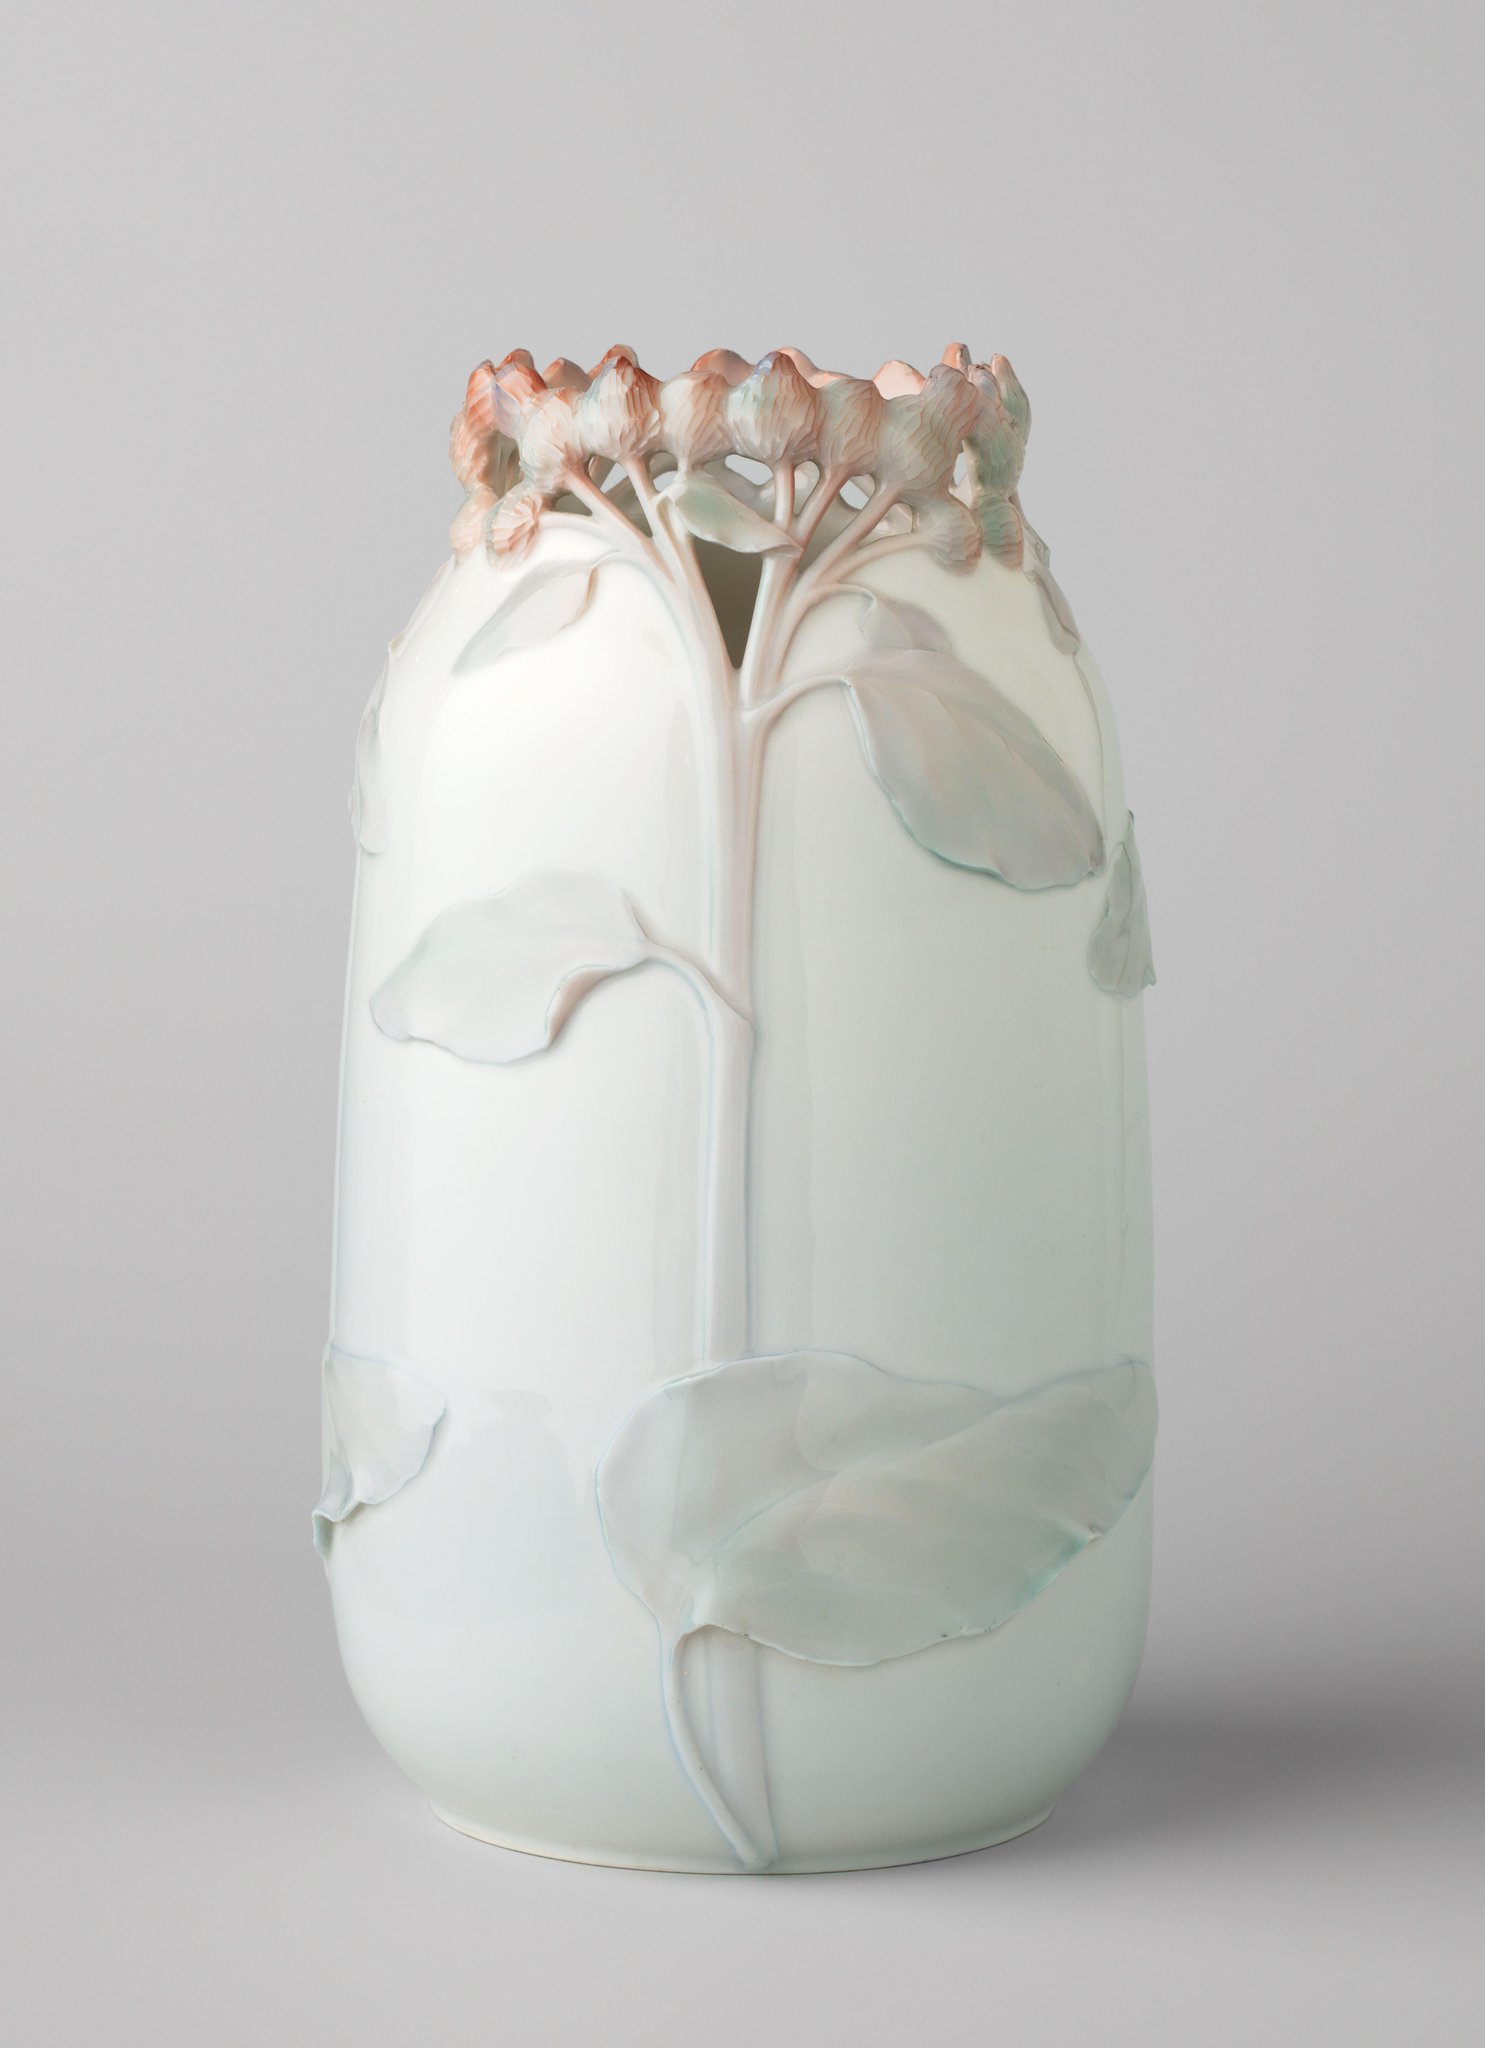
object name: vase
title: Vase with flowering plants in relief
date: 1900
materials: glaze, paint, porcelain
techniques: embroidery, firing, forming, relief, vitrification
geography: berlin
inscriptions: mark: ‘scepter/ 38E10/ J in spiegelbeeld/ 6495/ M15 en 6811’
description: Vaas van porselein met een cilindrische buik, rond aflopend naar de nek en de voet. De schouder en nek zijn opengewerkt. Beschilderd in onderglazuur blauw, rood en groen. Vanuit de voet naar boven driemaal een bloeiende plant in reliëf. De rand wordt gevormd door de bloemknoppen van de planten. Gemerkt op de onderzijde met de scepter, de cijfers 38E10, de letter J in spiegelbeeld, het modelnummer 6495 (december 1900) en de nummers M15 en 6811. Art Nouveau.